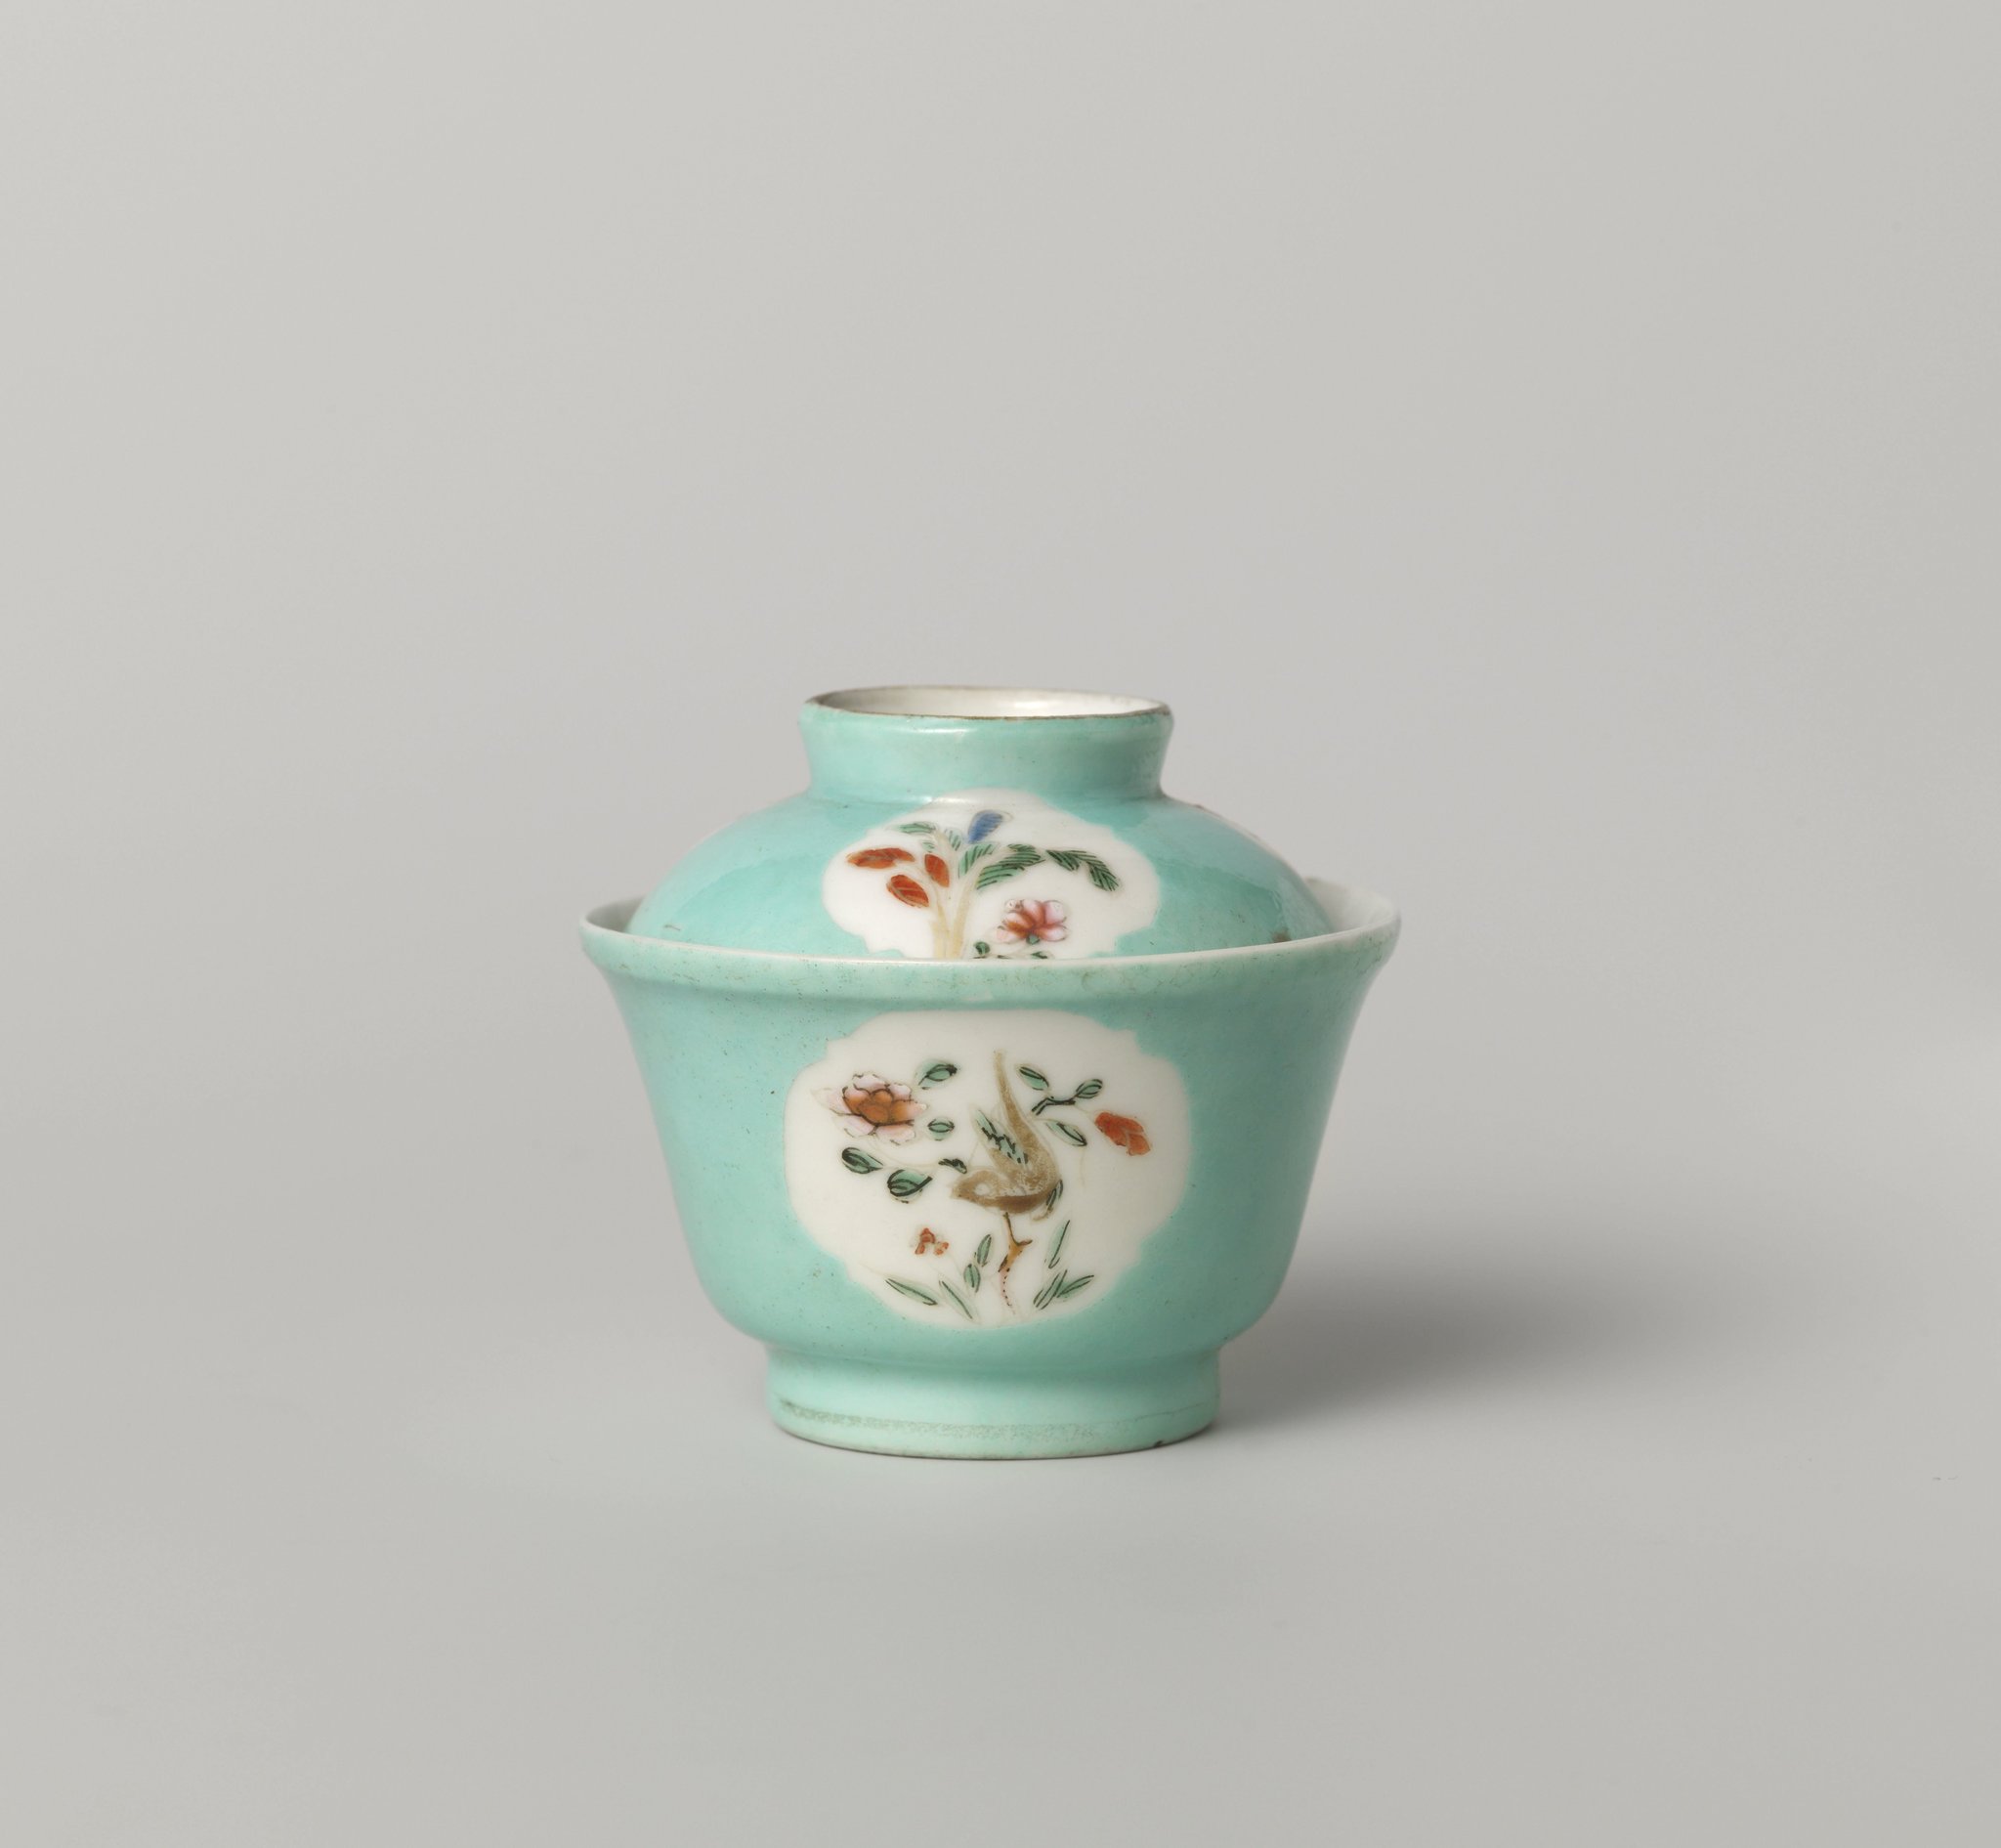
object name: lid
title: Bell-shaped covered cup with flowering plants in shaped panels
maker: Anonymous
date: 1760-1780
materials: glaze, gold, paint, porcelain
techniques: firing, gilding, turning, vitrification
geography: china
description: Deksel van klokvormige kop van porselein, bedekt met een turquoise glazuur en berschilderd in blauw, rood, roze, groen, zwart en goud. Bedekt met een turquoise glazuur met hierin uitgespaard in het centrum een geschulpt medaillon met plant, daaromheen drie uitgespaarde cartouches met bloeiende planten en een vogel op een tak. Famille rose.